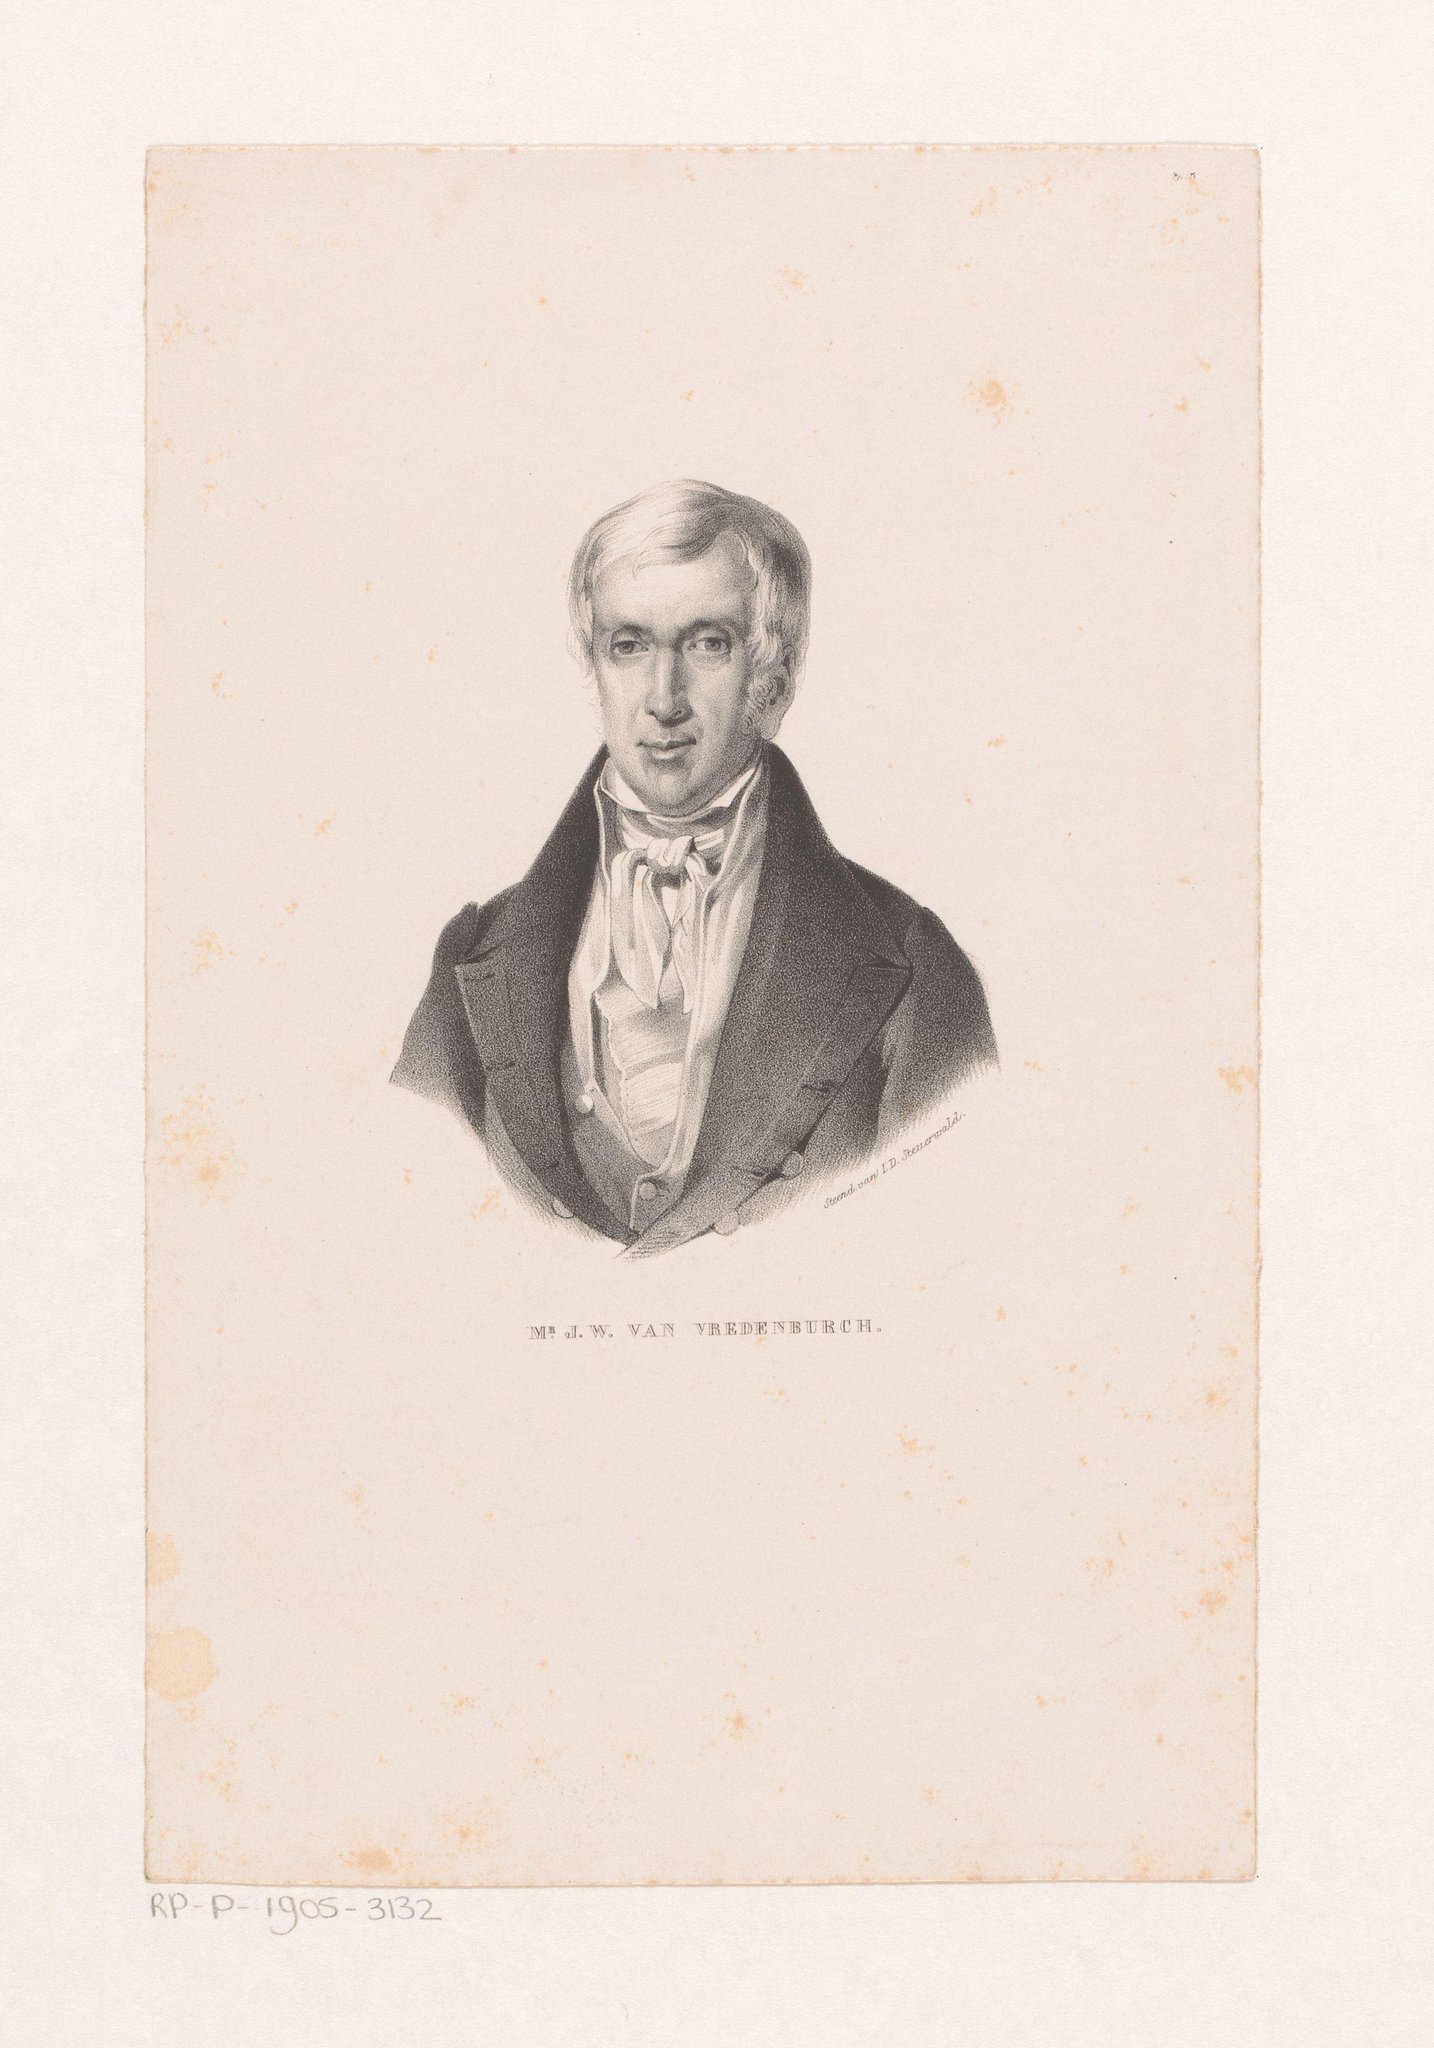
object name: print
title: Mr. J.W. van Vredenburch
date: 1822-1863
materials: paper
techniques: lithograph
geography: netherlands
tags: historical persons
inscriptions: collector's mark: Lugt 2228